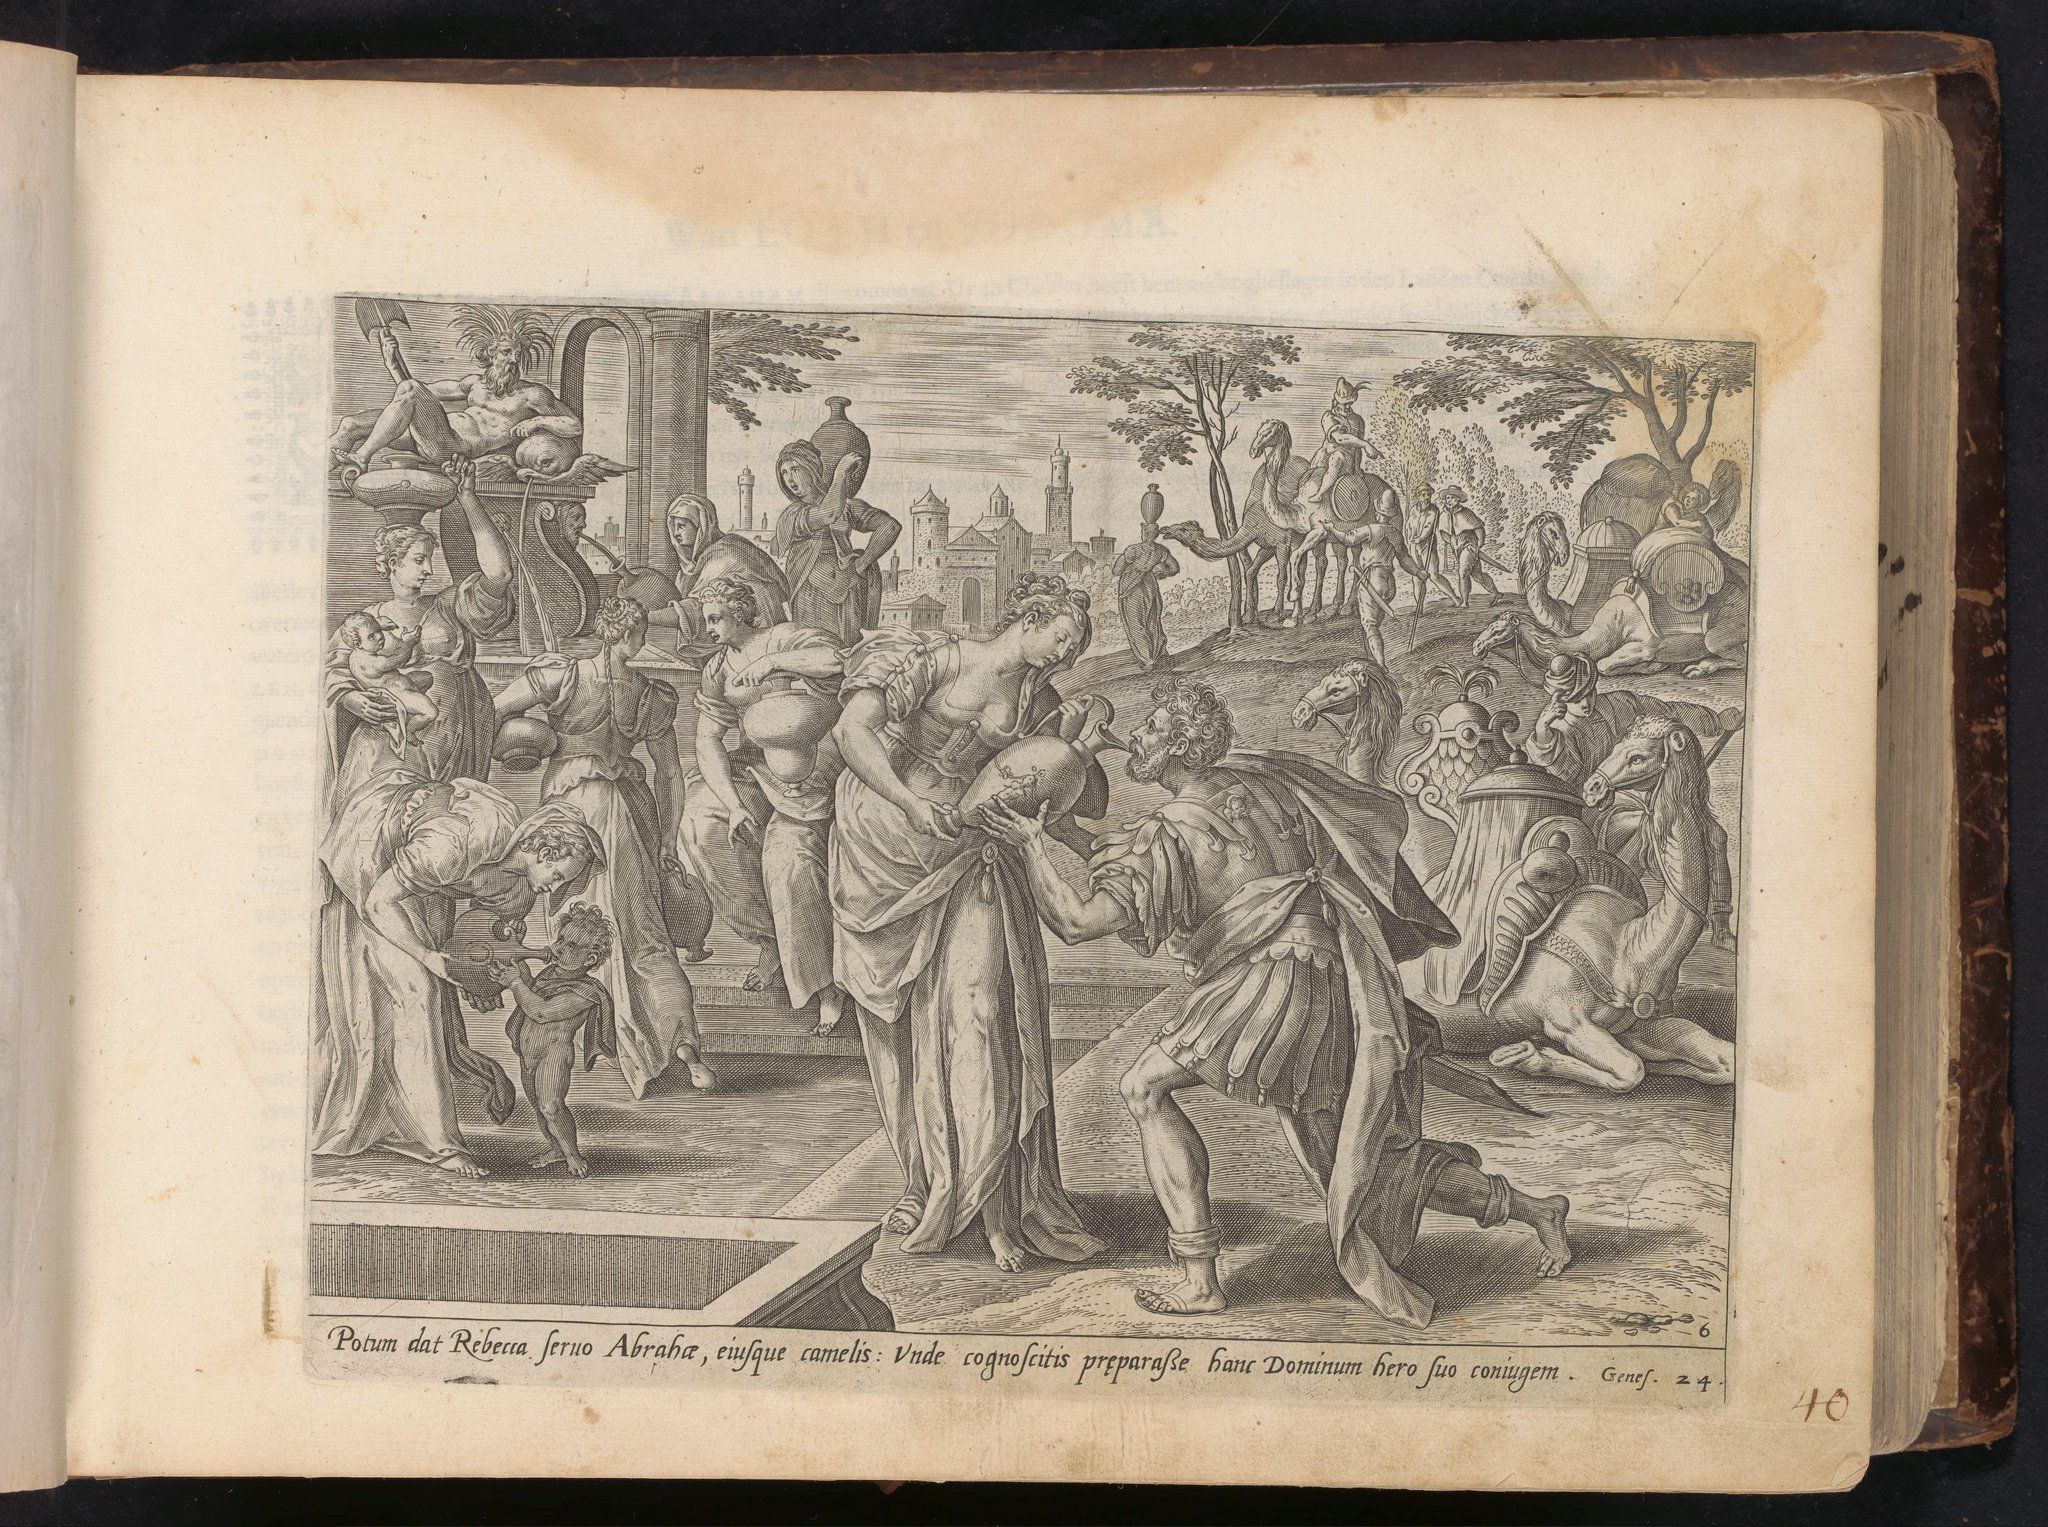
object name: album leaf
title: Geschiedenis van Abraham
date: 1585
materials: paper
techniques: engraving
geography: amsterdam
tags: the meeting at the well: eliezer sees rebekah coming with a pitcher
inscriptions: number: ‘40’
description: Eliëzer, de knecht van Abraham, ontmoet Rebekka bij de waterput. Zij laat hem drinken uit haar kruik. Rechts de kamelen en het gevolg van Eliëzer. Links komen de vrouwen uit de stad water halen bij de fontein. De fontein wordt bekroond door een riviergod. Onder de voorstelling een verwijzing in het Latijn naar de Bijbeltekst in Gen. 24. Deze prent maakt deel uit van een album.